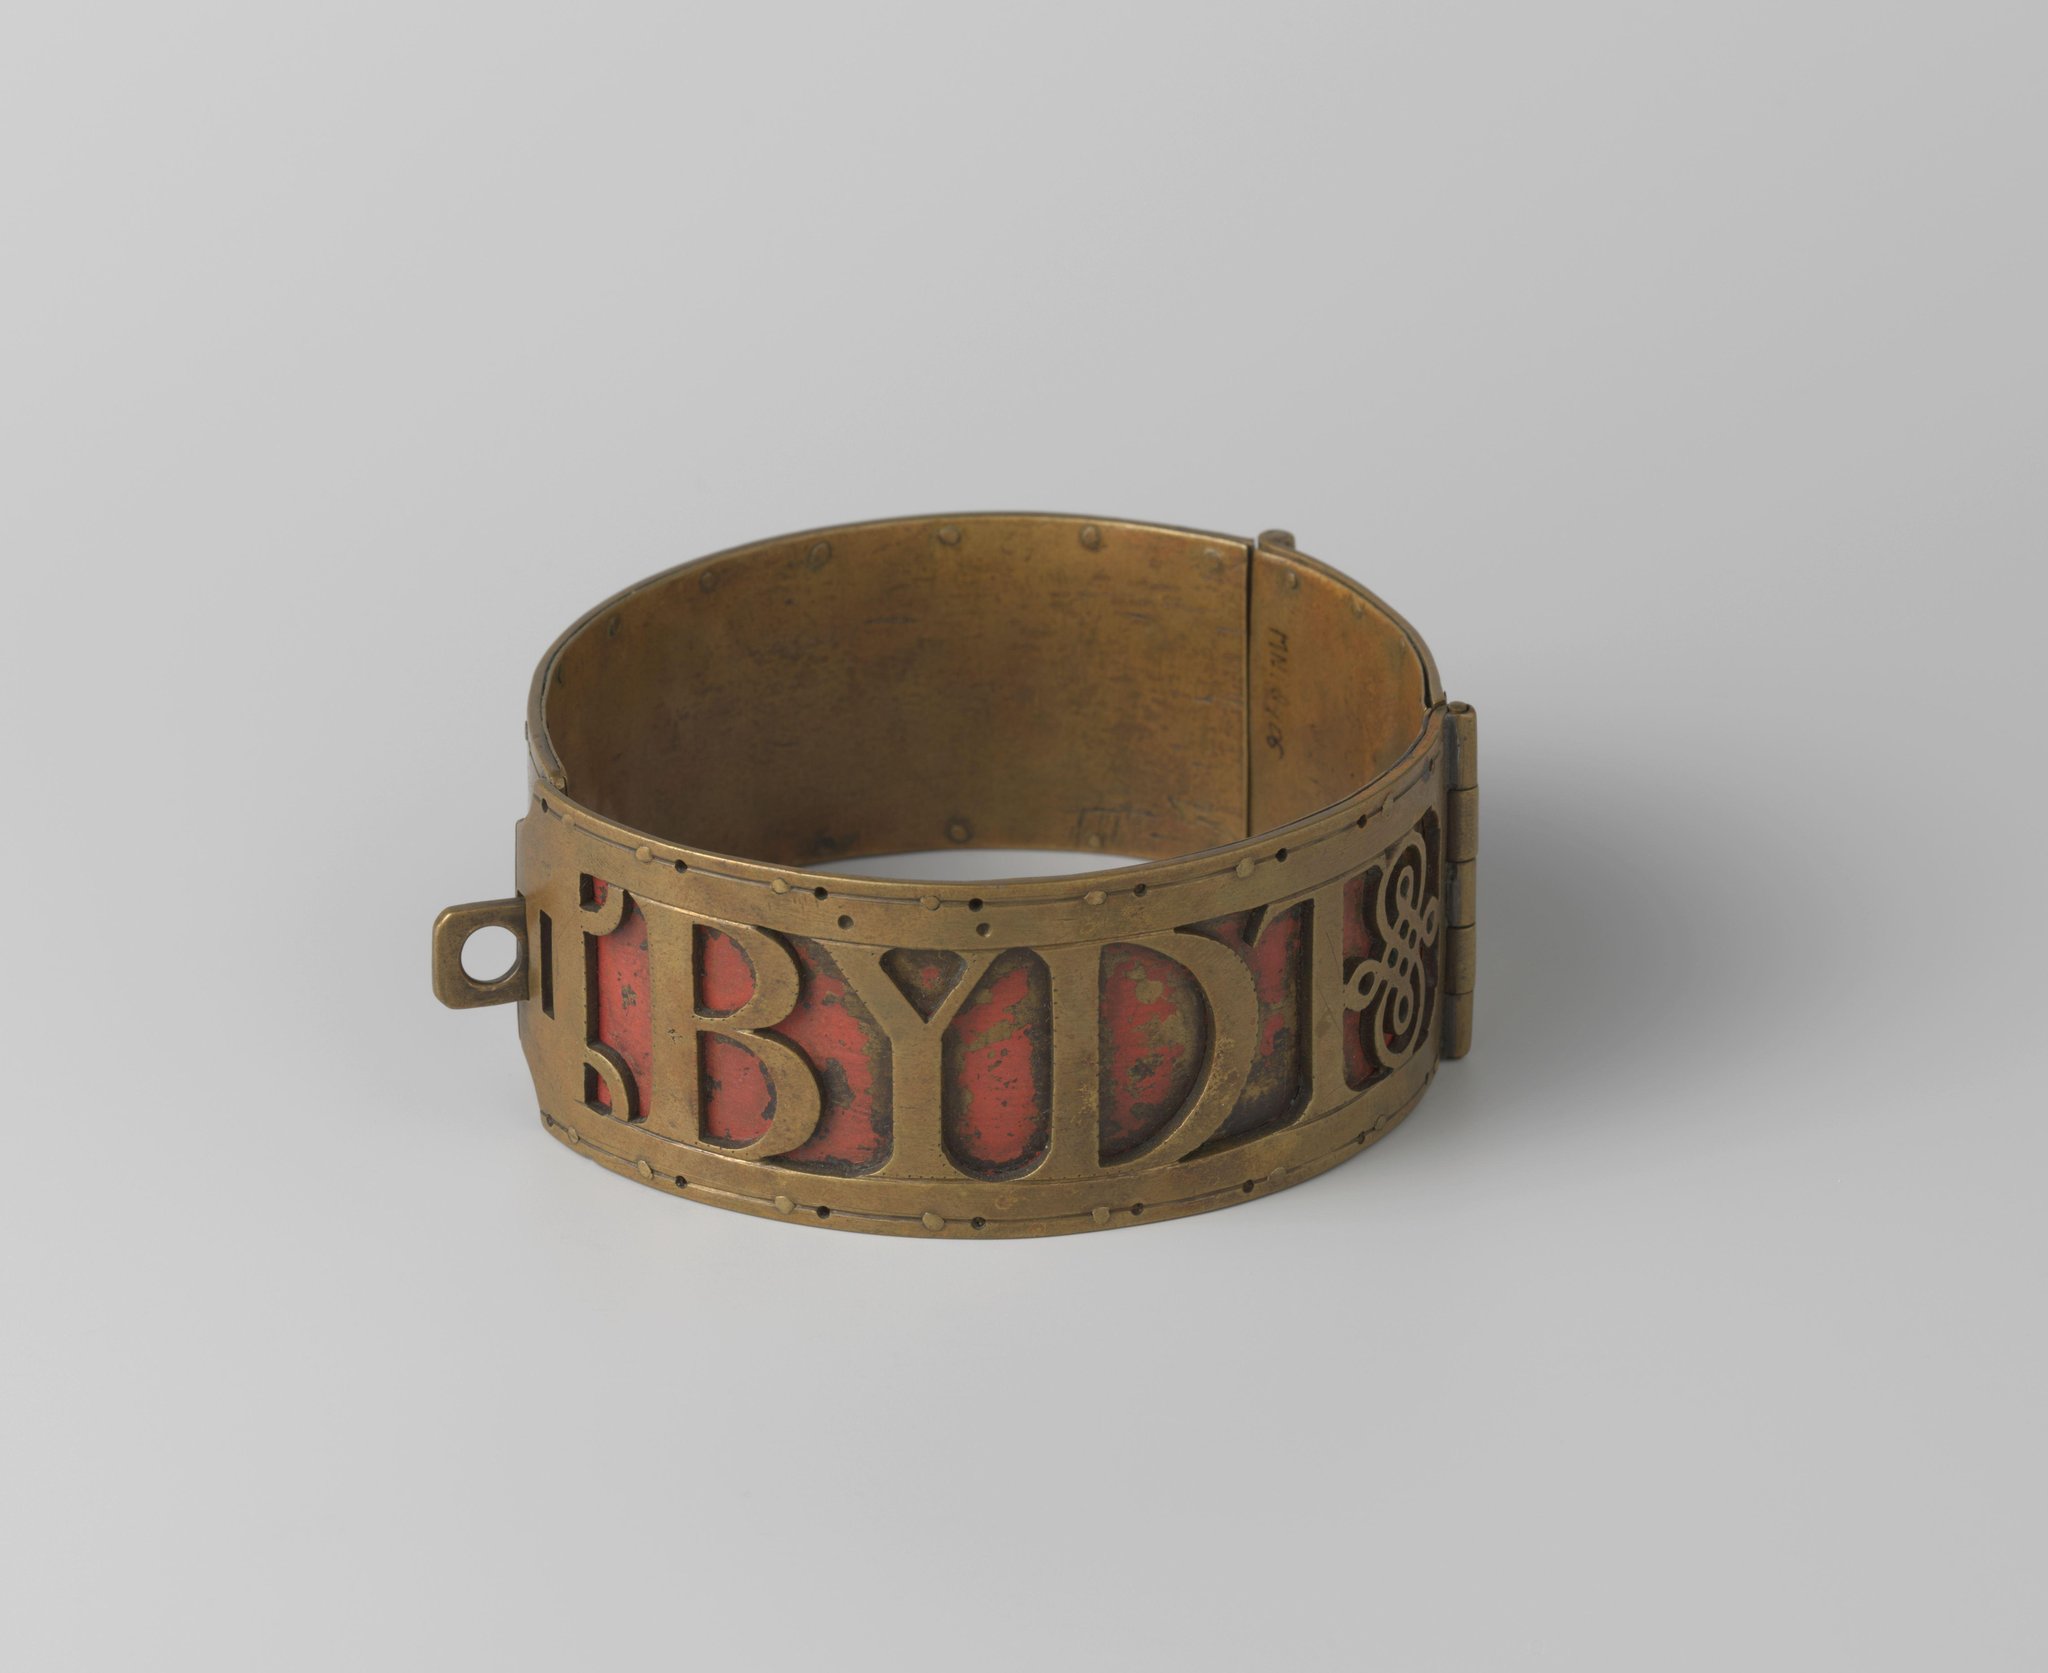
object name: halsband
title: Halsband met het opschrift: BYDT NIET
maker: Anonymous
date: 1600-1650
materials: brass, paint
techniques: cutting, embroidery, painting, riveted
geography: netherlands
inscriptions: inscription: ‘BYDT NIET’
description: Het uit plaat gesneden voorwerp bestaat uit een kort stuk en twee lange delen, welke met scharnieren zijn verbonden. De einden zijn voorzien van een oogsluiting. In het korte deel is een rozet uitgezaagd, in de andere twee een daaraan verwant ornament alsmede in Latijnse majuskels het opschrift: BYDT NIET. Tegen deze delen is aan de binnenkant koperplaat geklonken, dat naar buiten toe rood is geverfd, om ornament en tekst te laten uitkomen.